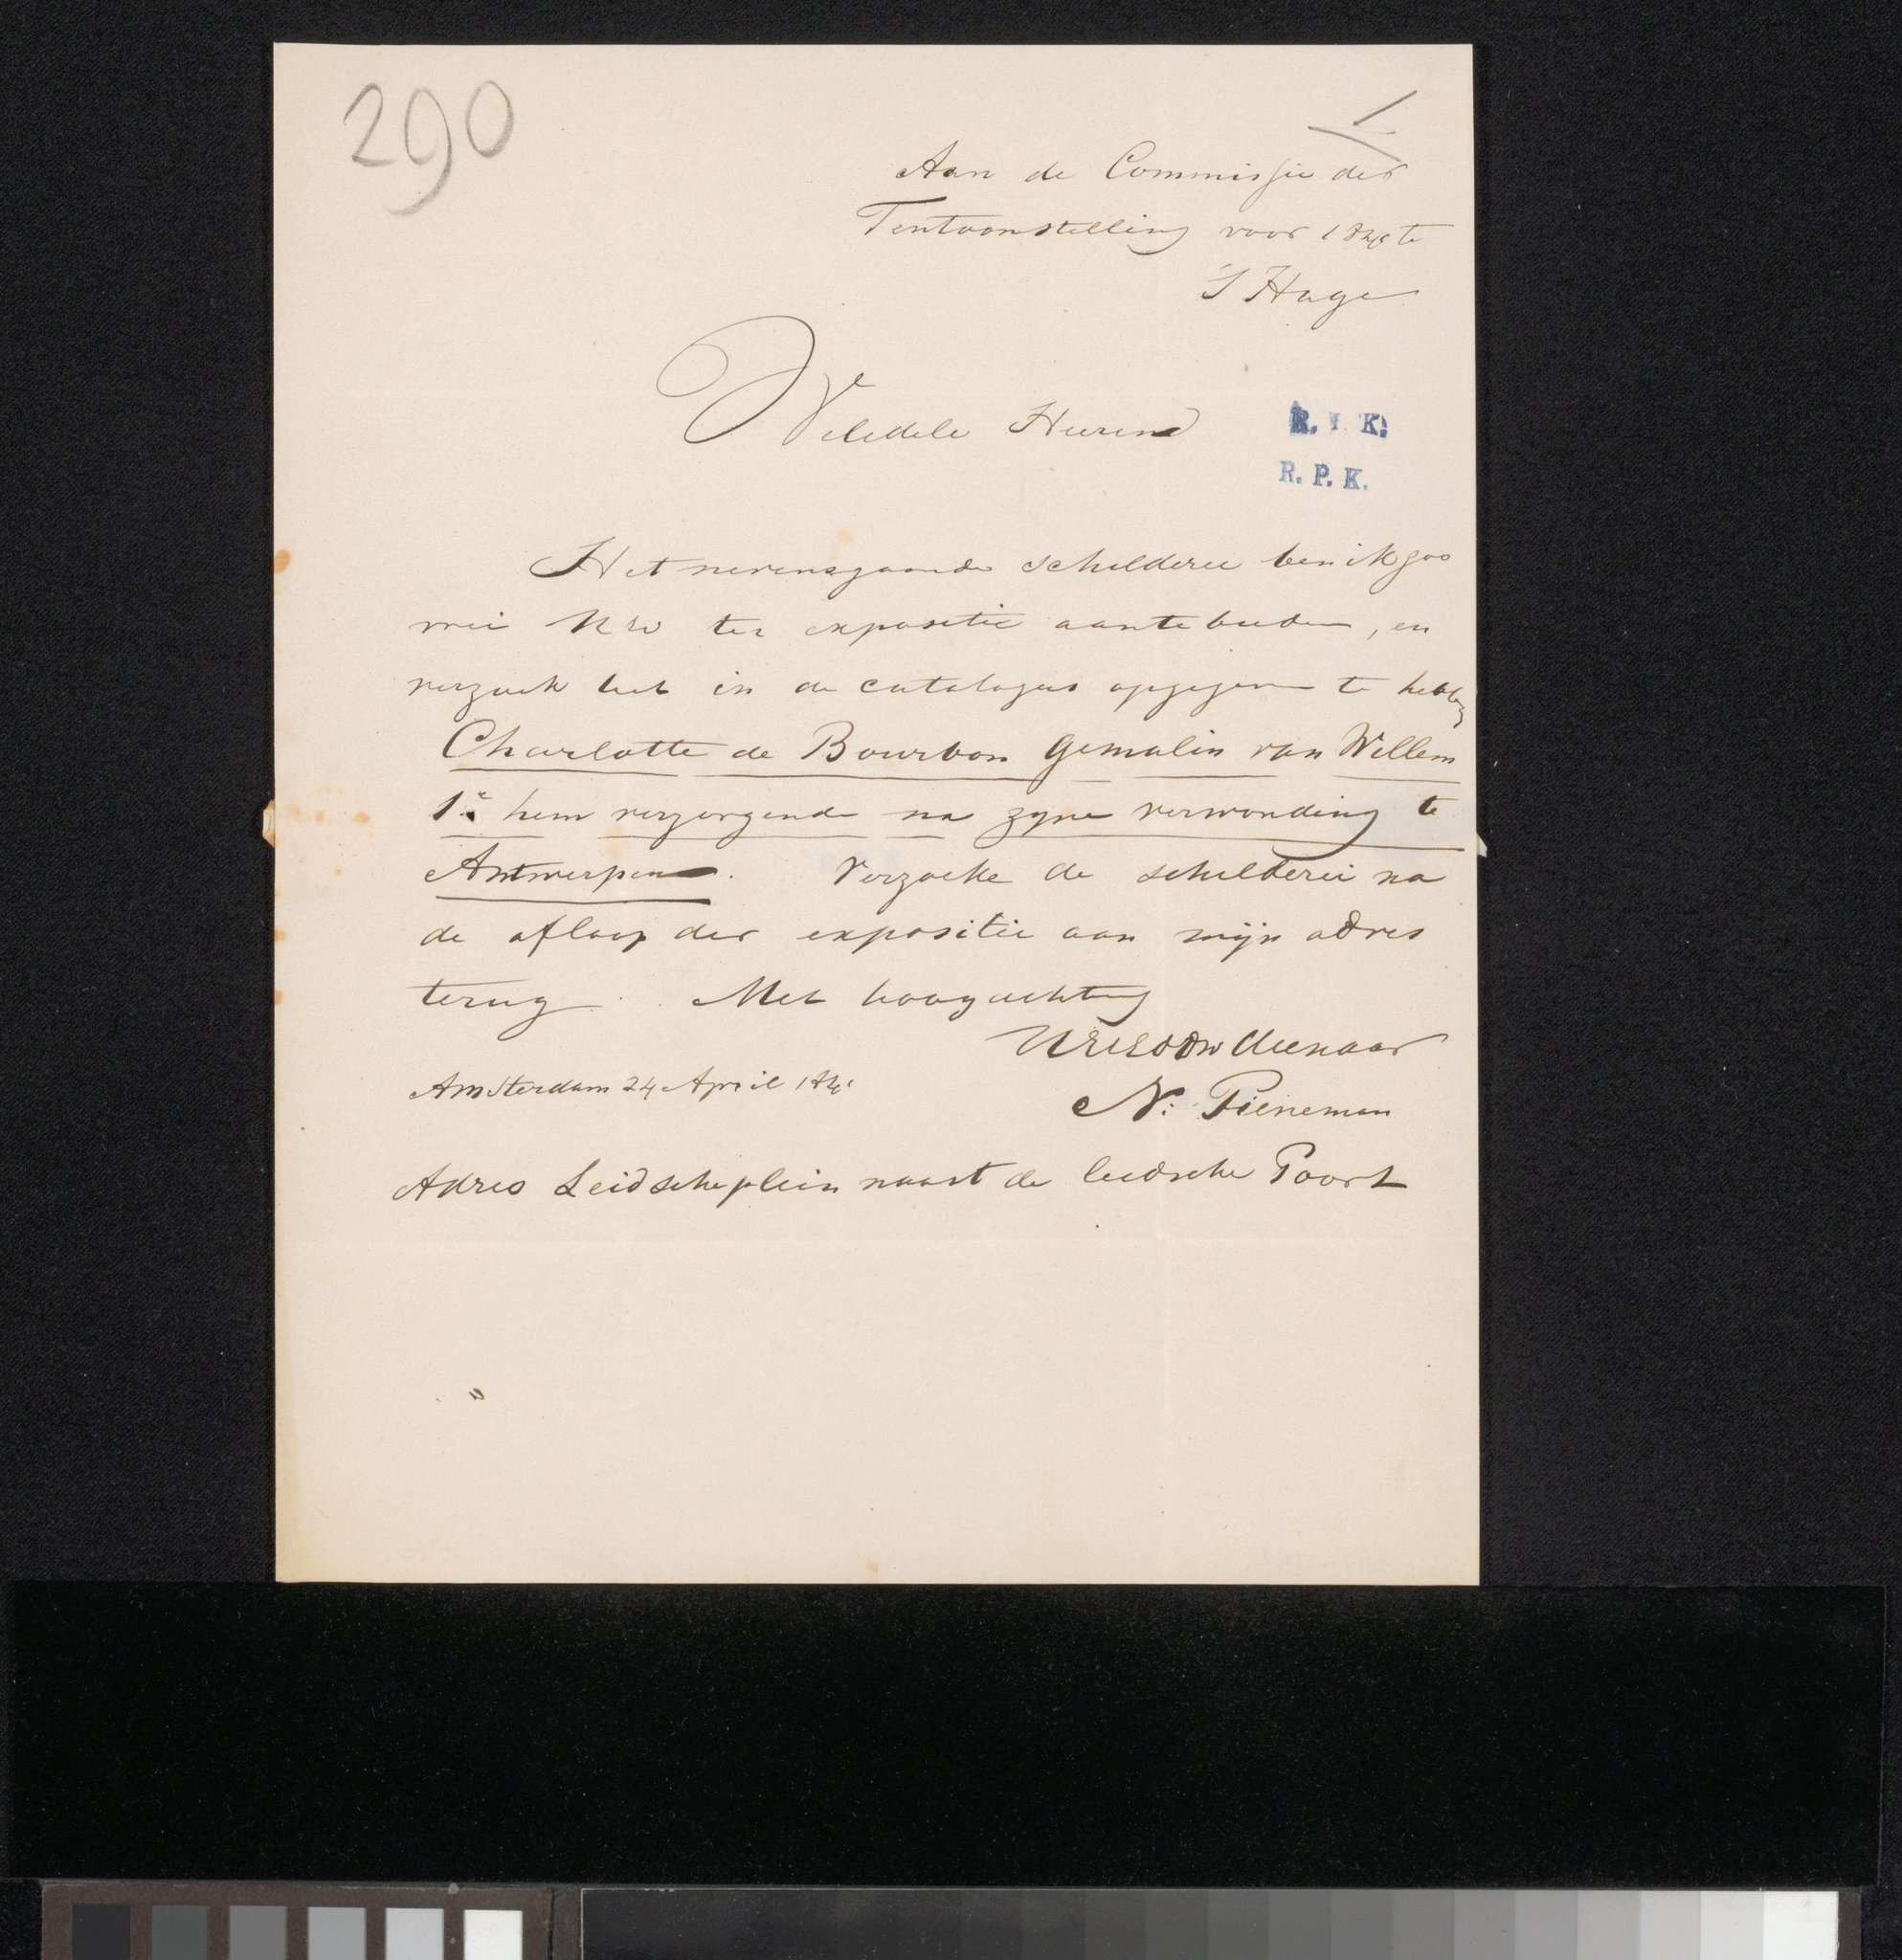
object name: letter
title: Brief aan de Commissie van de Tentoonstelling van Levende Meesters in Den Haag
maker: nicolaas pieneman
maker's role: draughtsman, painter, print maker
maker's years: 1809-1860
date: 1841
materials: ink, paper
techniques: pen, writing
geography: amsterdam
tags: painting (including book-illumination, miniature-painting), exhibition ~ art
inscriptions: collector's mark: Lugt 2233